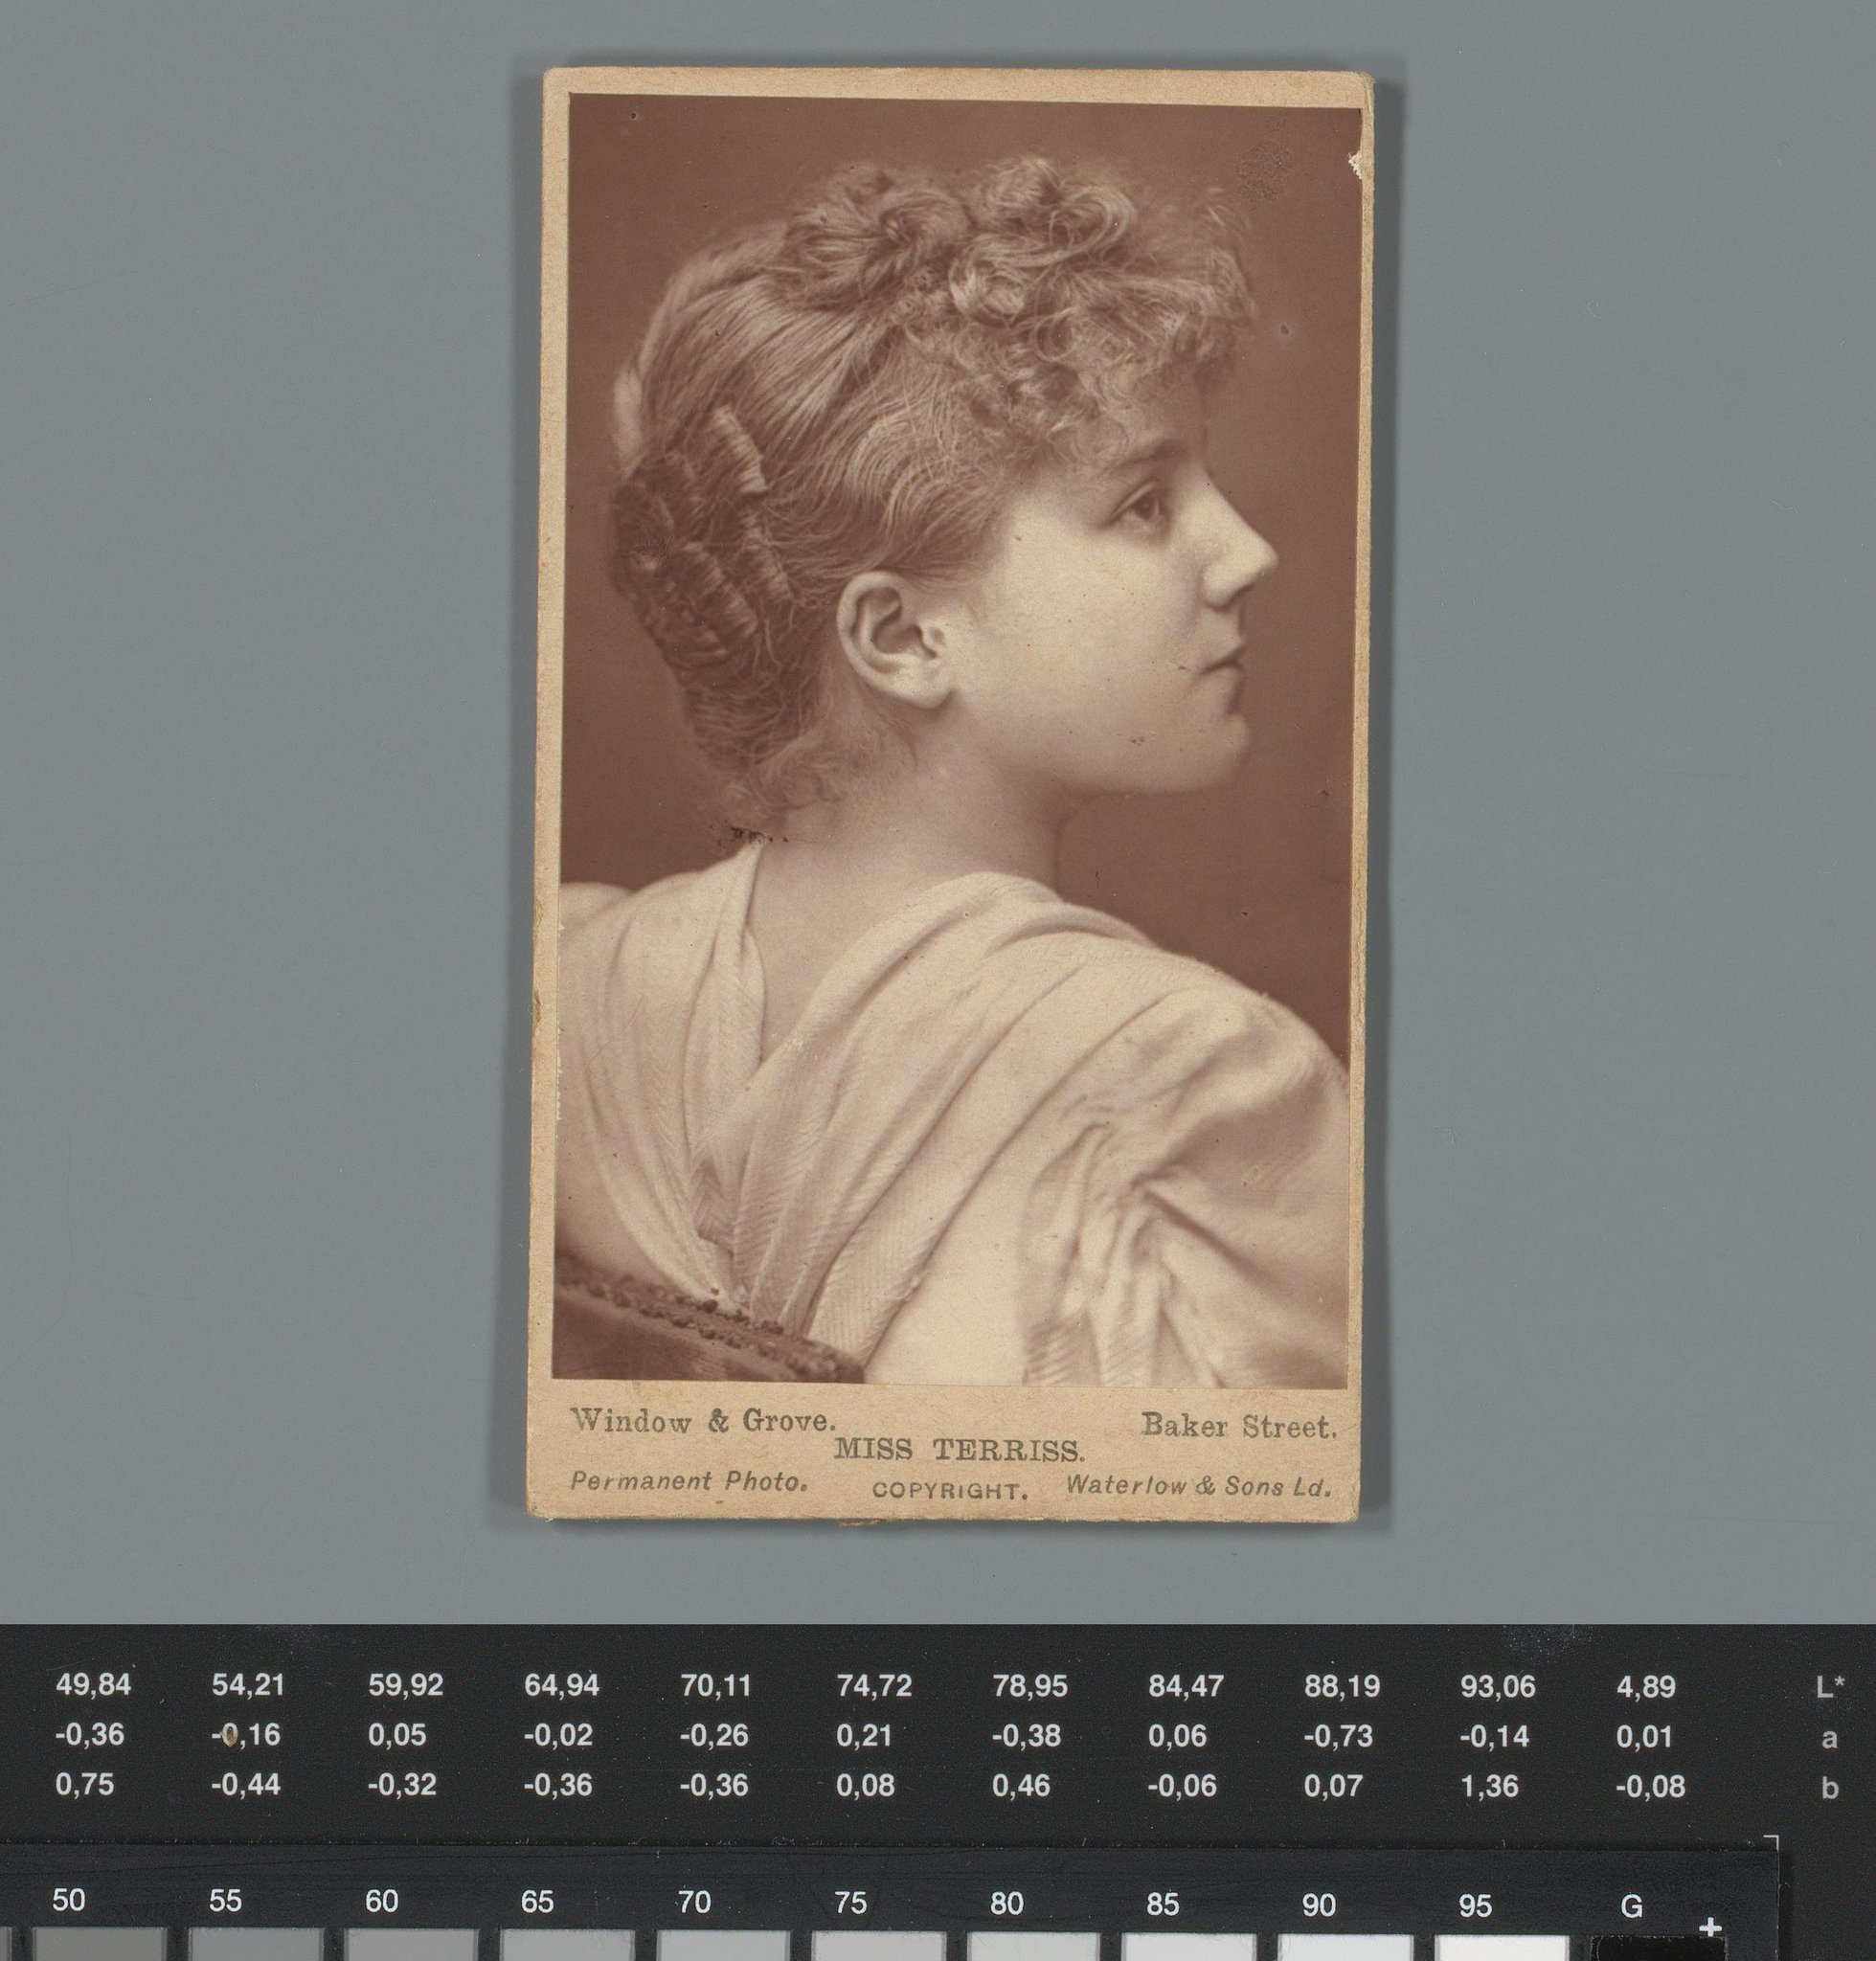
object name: carte de visite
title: Miss Terriss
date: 1880-1915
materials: cardboard, photographic support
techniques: woodburytype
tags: advertising, historical persons - bb - woman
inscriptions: inscription: ‘(...)’, inscription: ‘Window & Grove. Baker Street./ Permanent Photo. COPYRIGHT. Waterlow & Sons Ld.’